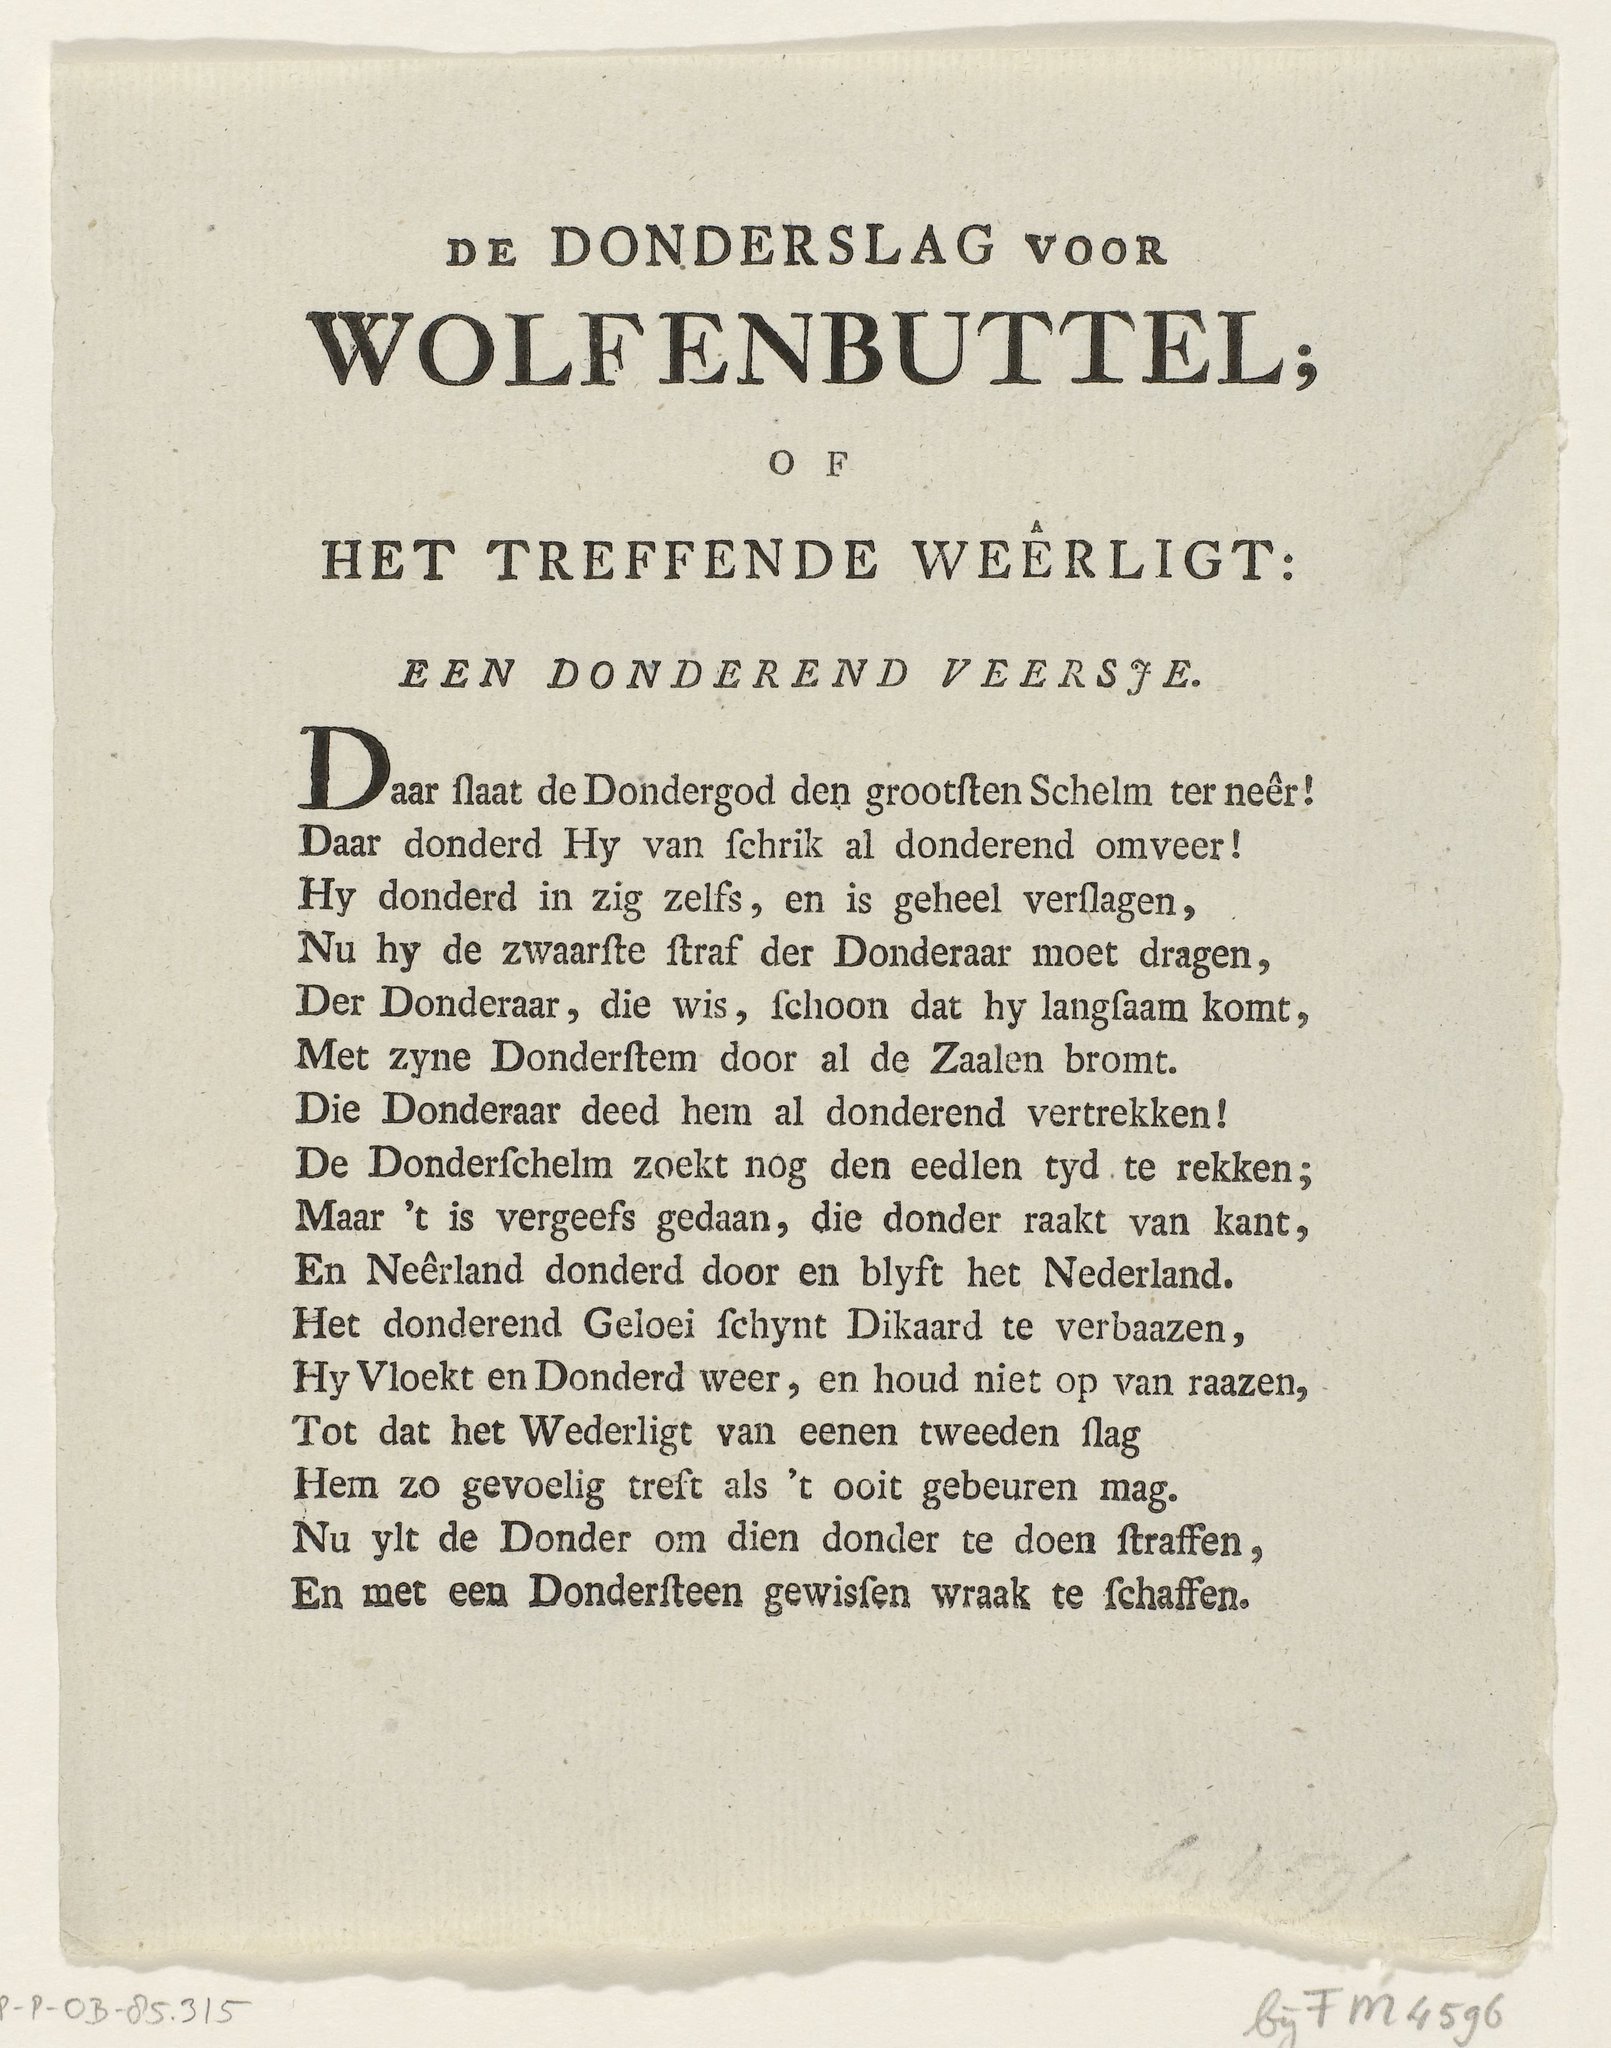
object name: text sheet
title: De Donderslag voor Wolfenbuttel; of Het Treffende Weerligt: een donderend veersje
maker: Anonymous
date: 1784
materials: paper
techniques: letterpress printing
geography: northern netherlands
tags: ludwig ernst von braunschweig-wolfenbüttel, patriots (1780-1795)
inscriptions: collector's mark: Lugt 2228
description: Tekstblad met een spotvers op Lodewijk Ernst, hertog van Brunswijk-Wolfenbüttel, 1784.